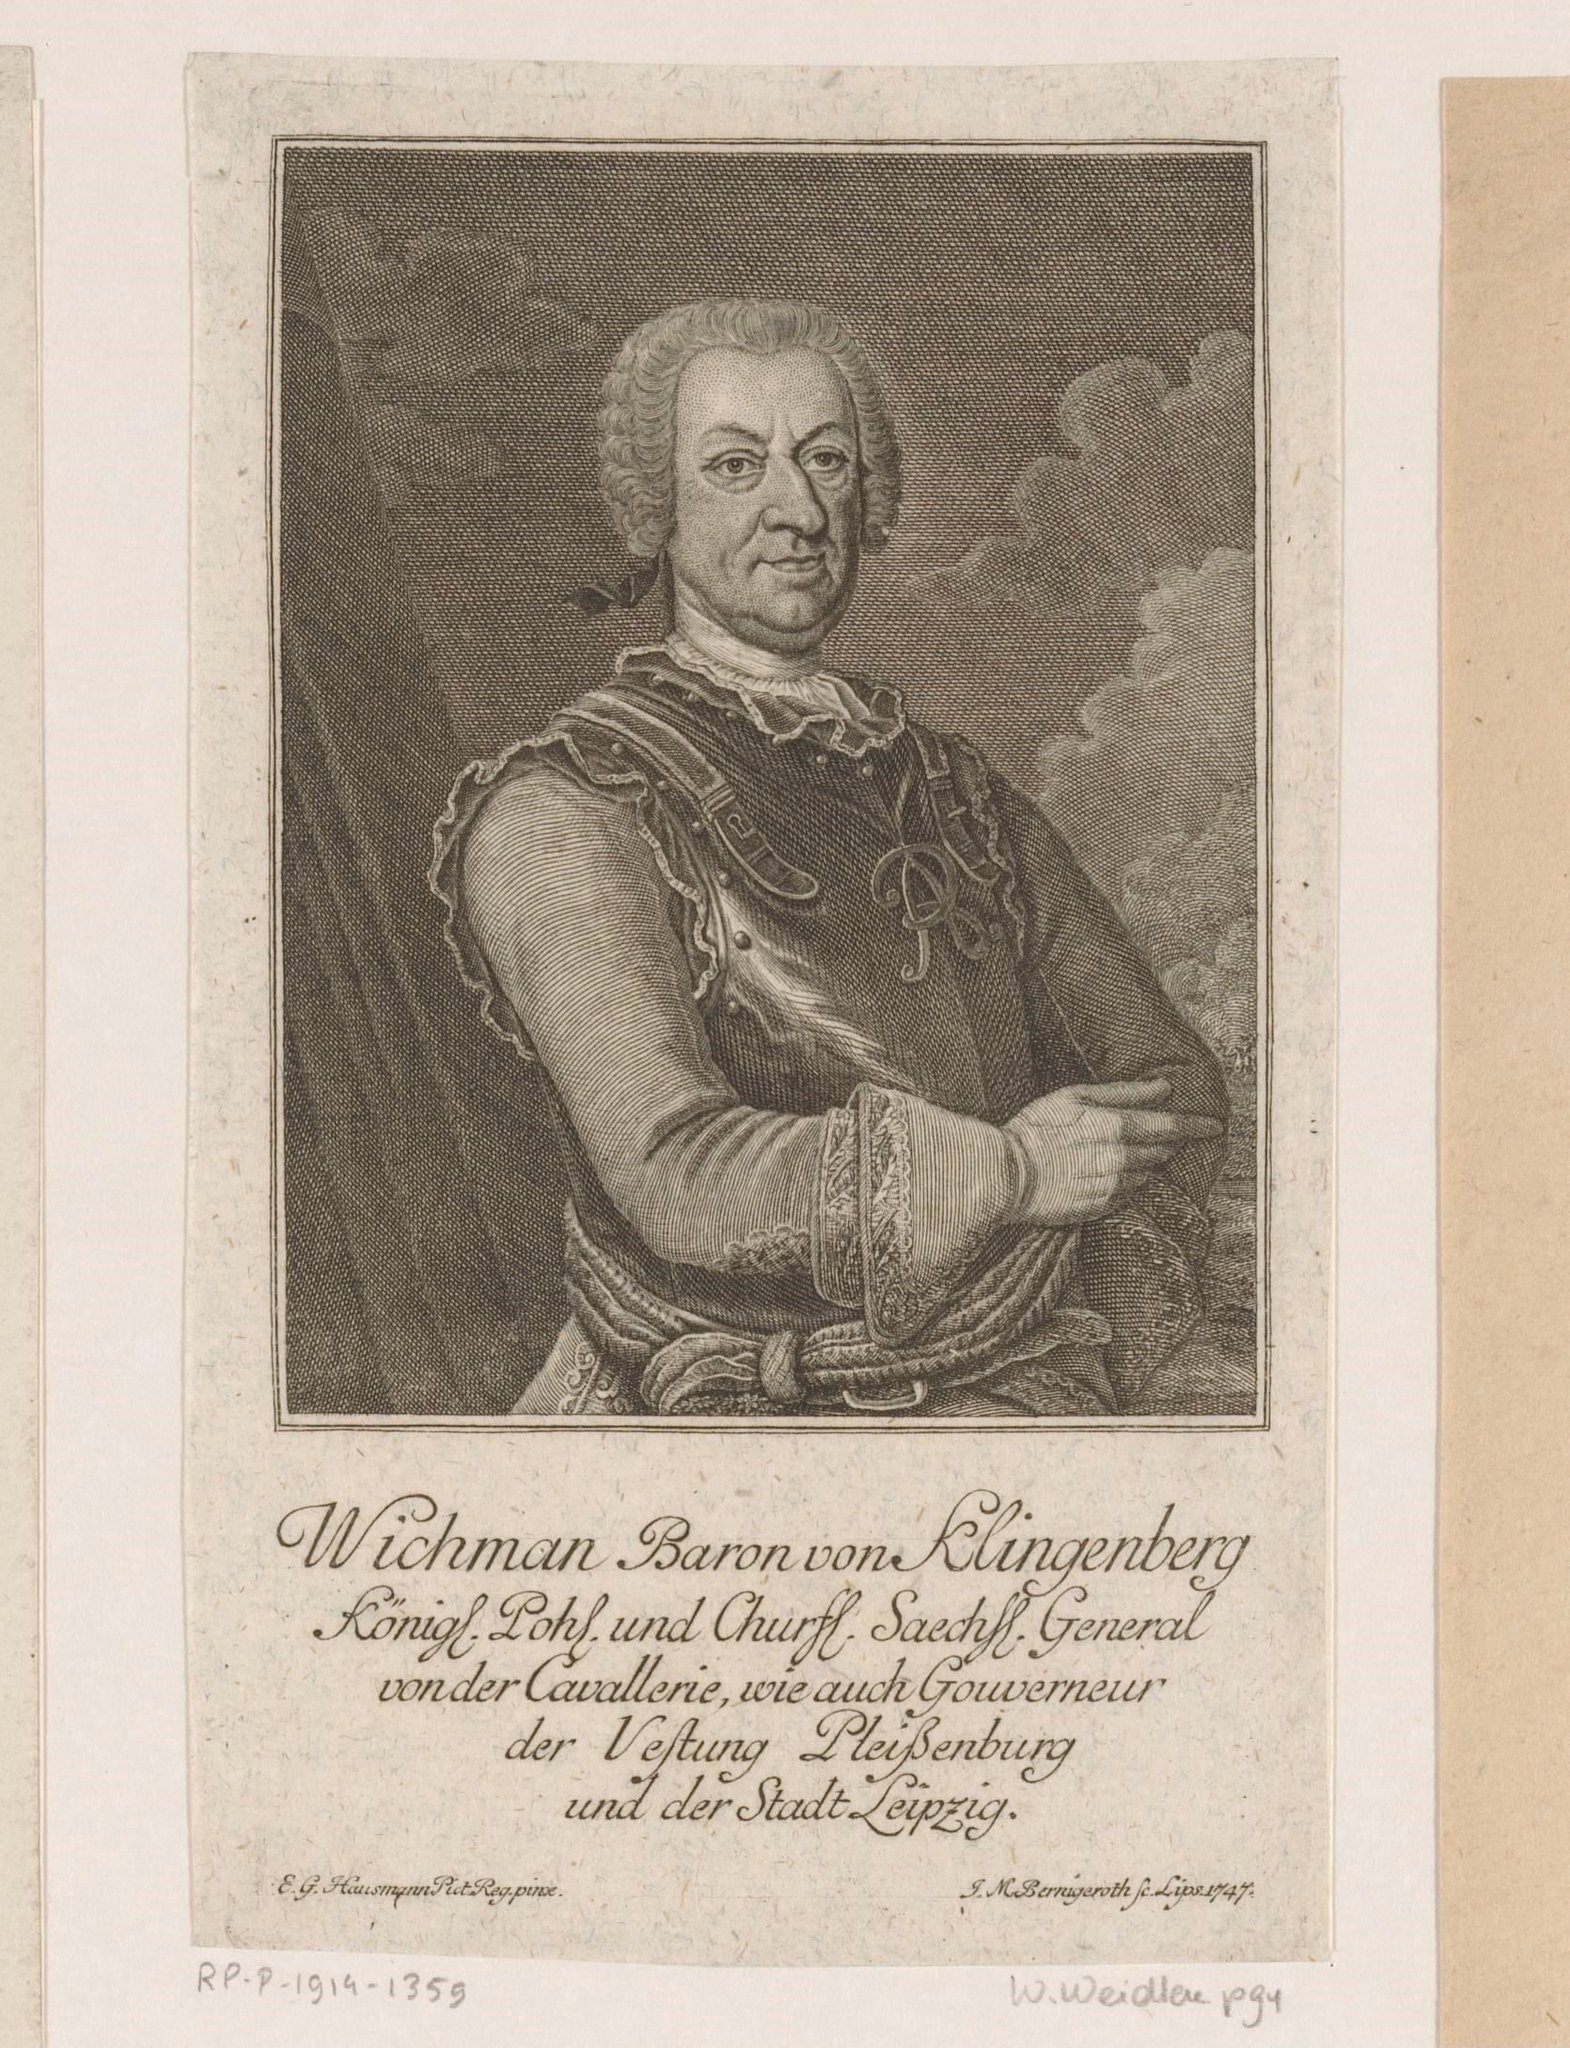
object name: print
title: Portret van Martin Chladni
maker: martin bernigeroth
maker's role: print maker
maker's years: 1670-1733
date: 1717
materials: paper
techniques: engraving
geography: leipzig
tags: historical persons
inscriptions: collector's mark: Lugt 2228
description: Prent ook gebruikt in: Deutsche Acta Eruditorum (...). dl. 49 Leipzig: Johann Gottlieb Gleditsch, 1717.